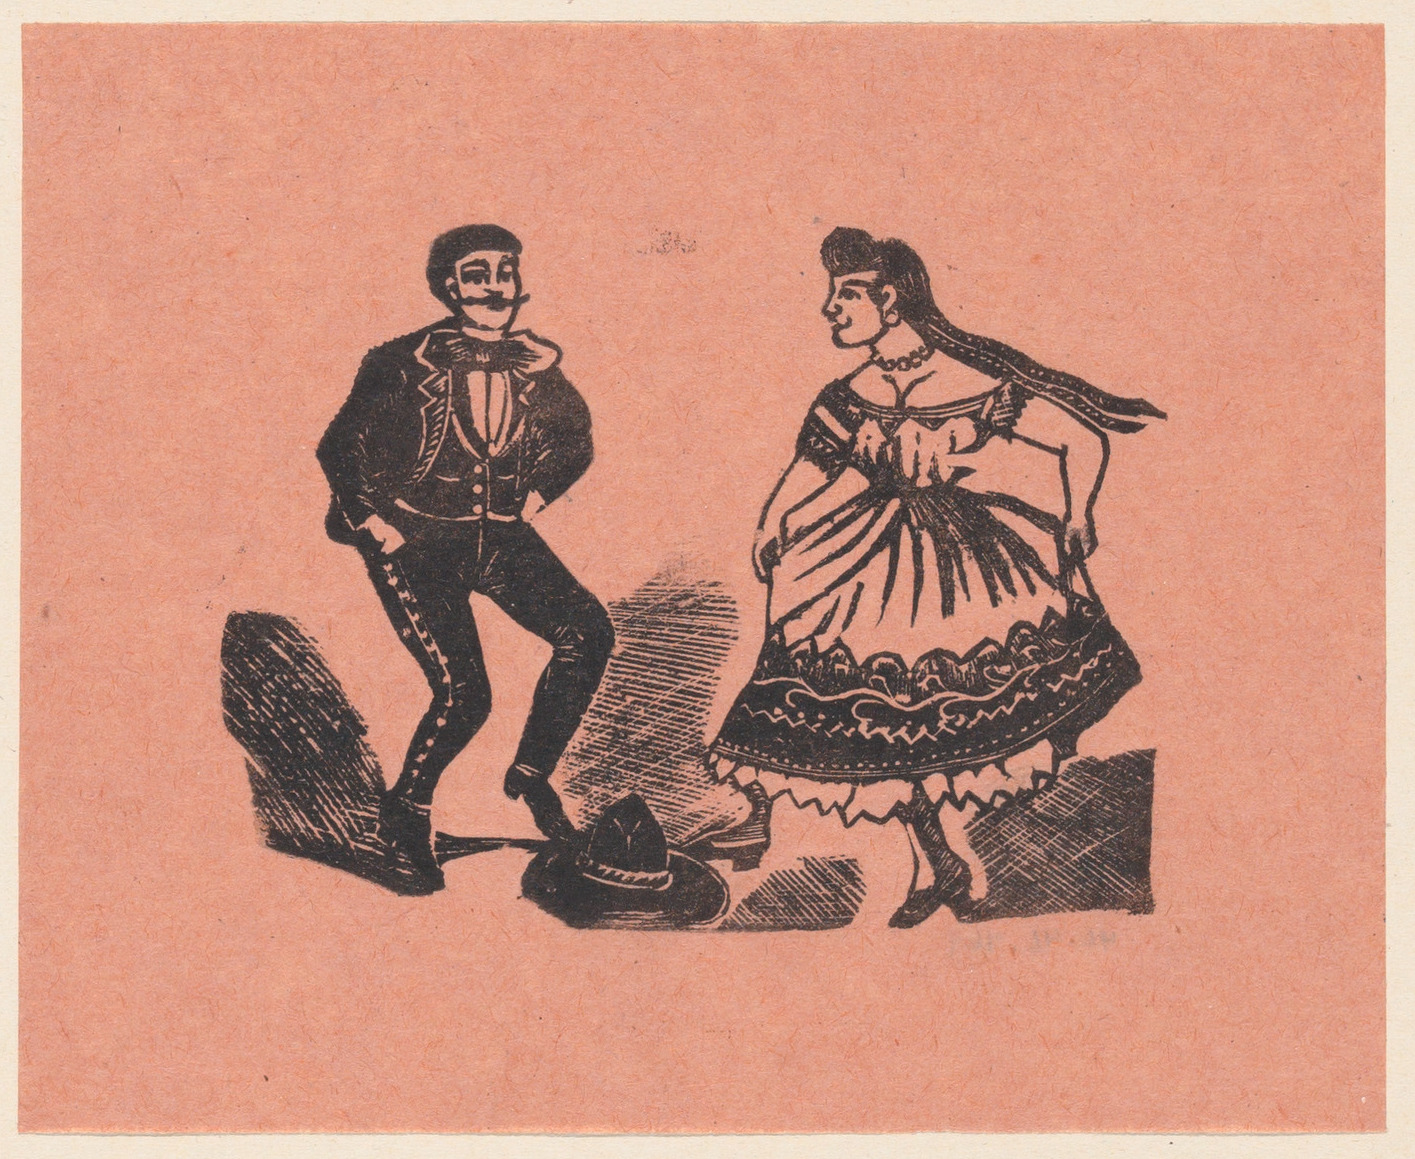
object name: print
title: Man and Woman Dancing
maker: josé guadalupe posada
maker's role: artist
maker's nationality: mexican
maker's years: 1852-1913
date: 1890-1910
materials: metal, paper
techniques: engraving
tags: men,women,dancing